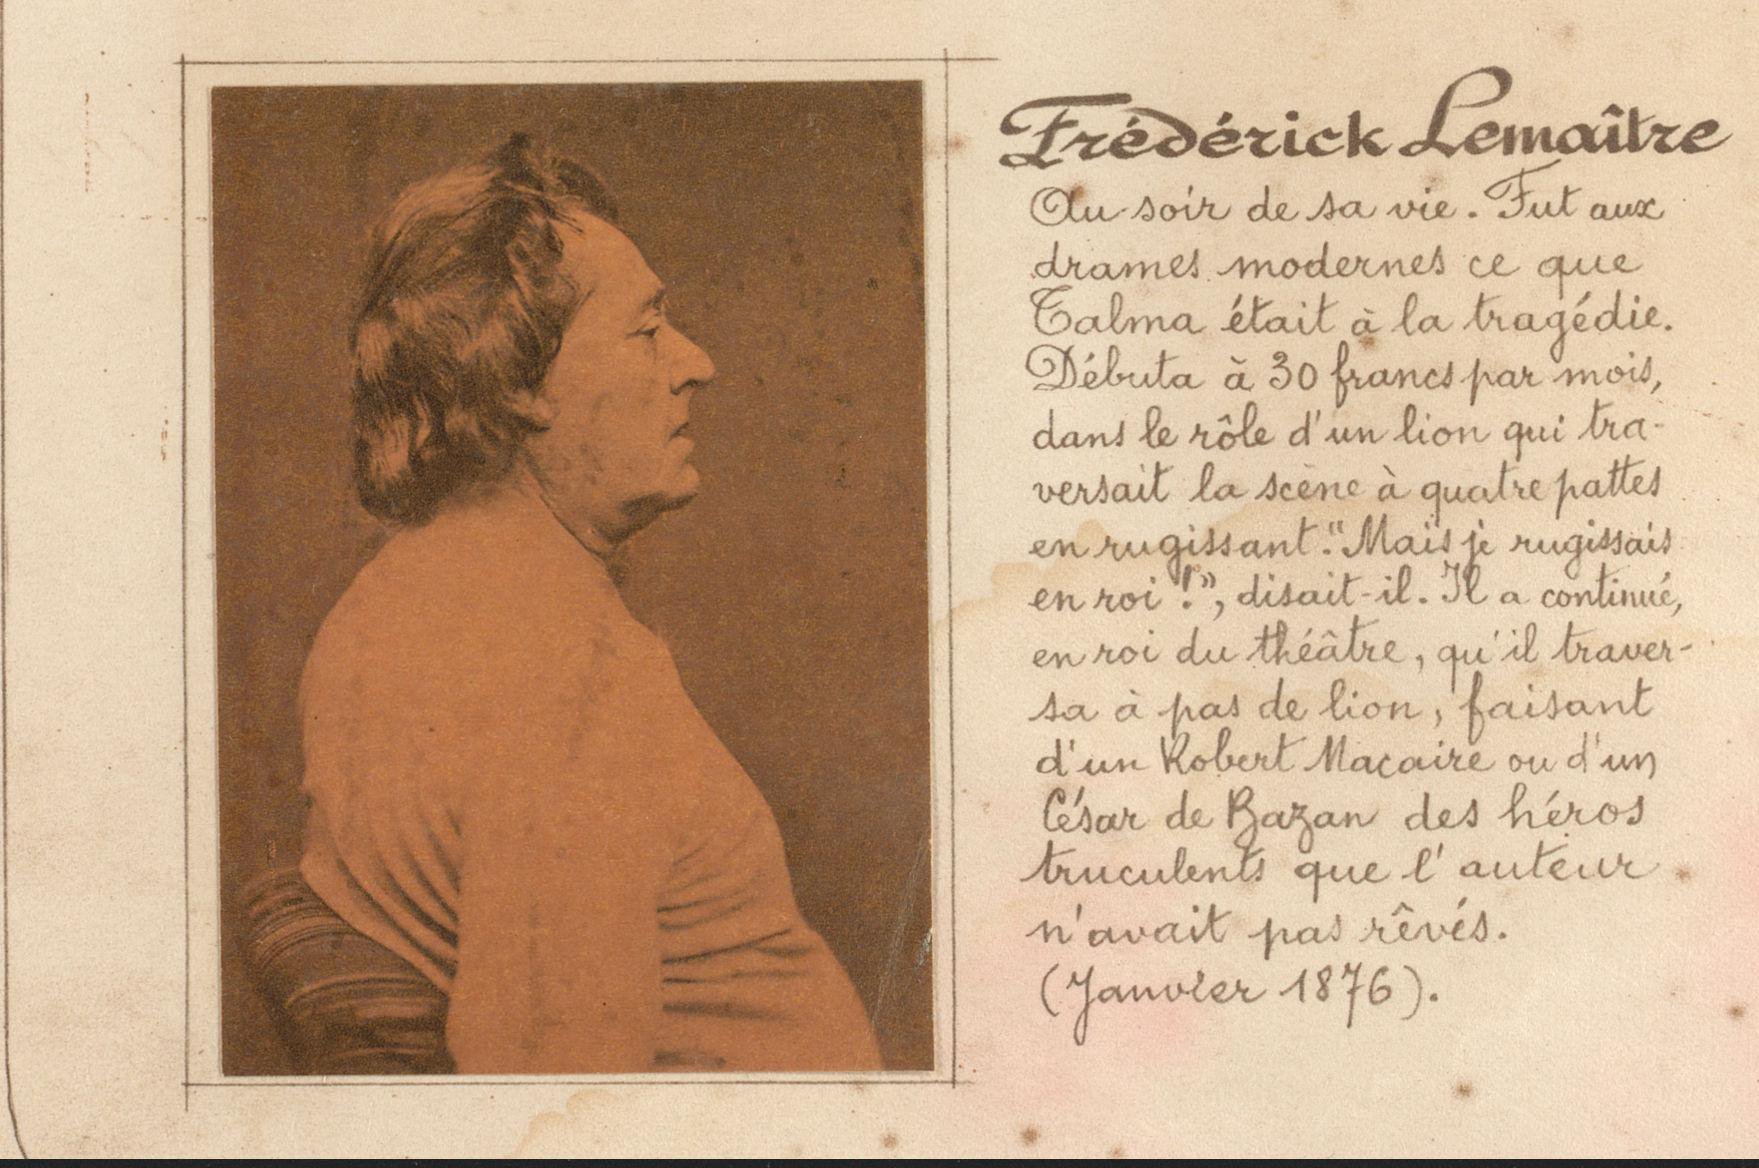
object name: album leaf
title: Frédérick Lemaître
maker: Anonymous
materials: paper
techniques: rotogravure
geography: france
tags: portrait of actor, actress, france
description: Deze prent maakt deel uit van een album.